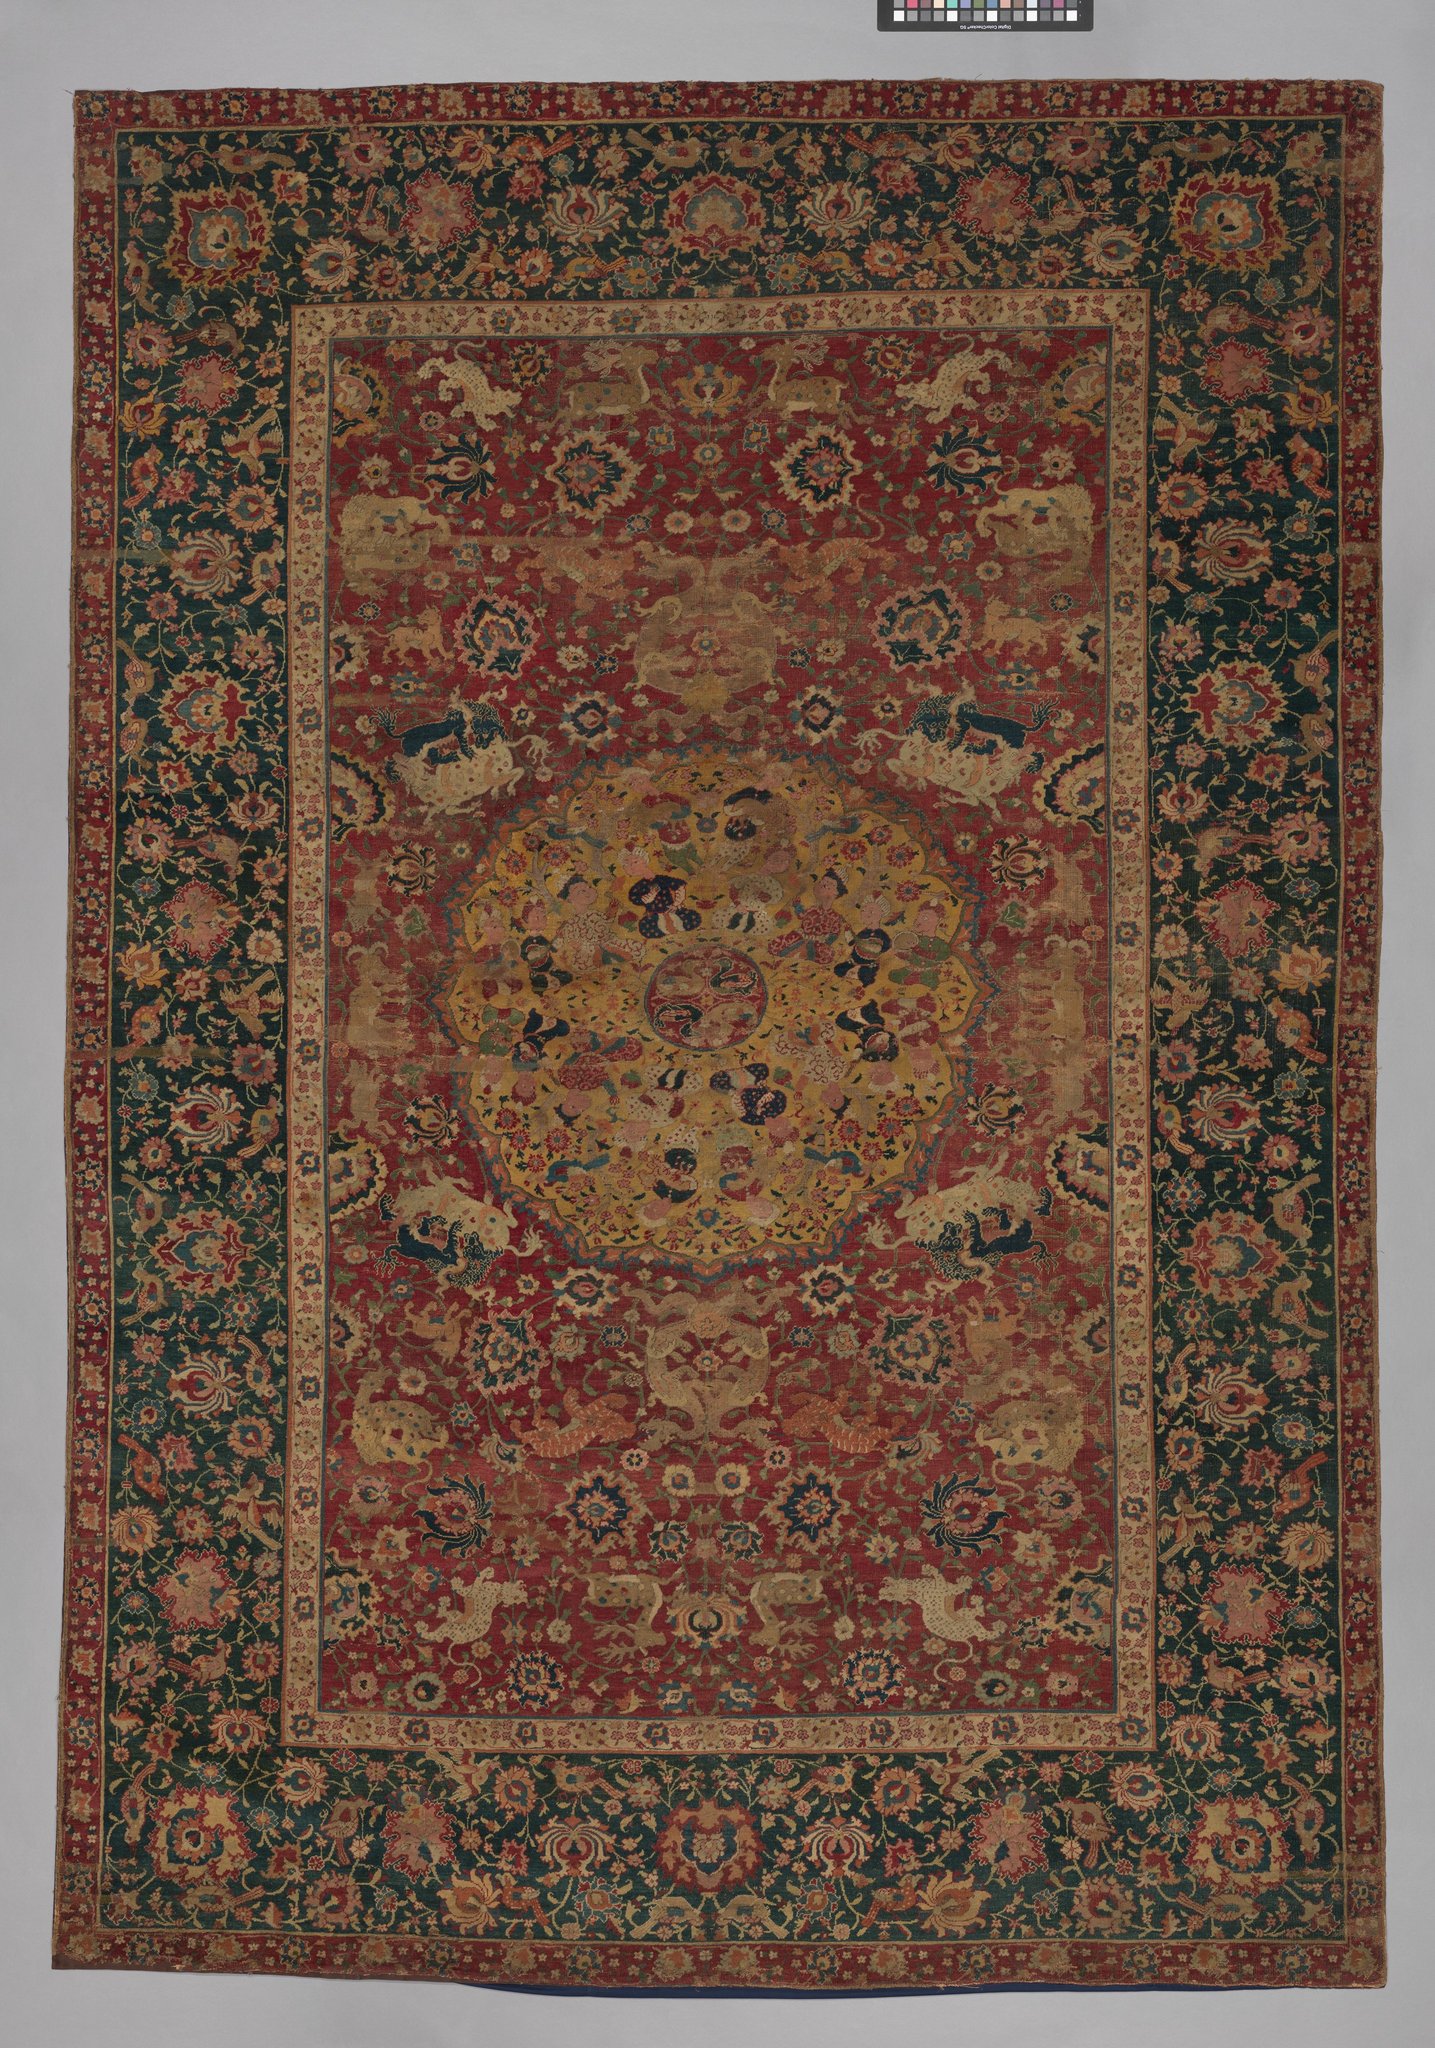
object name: carpet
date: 1551-1600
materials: cotton, silk, wool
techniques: asymmetrically knotted pile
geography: iran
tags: animals,men,deer,tigers